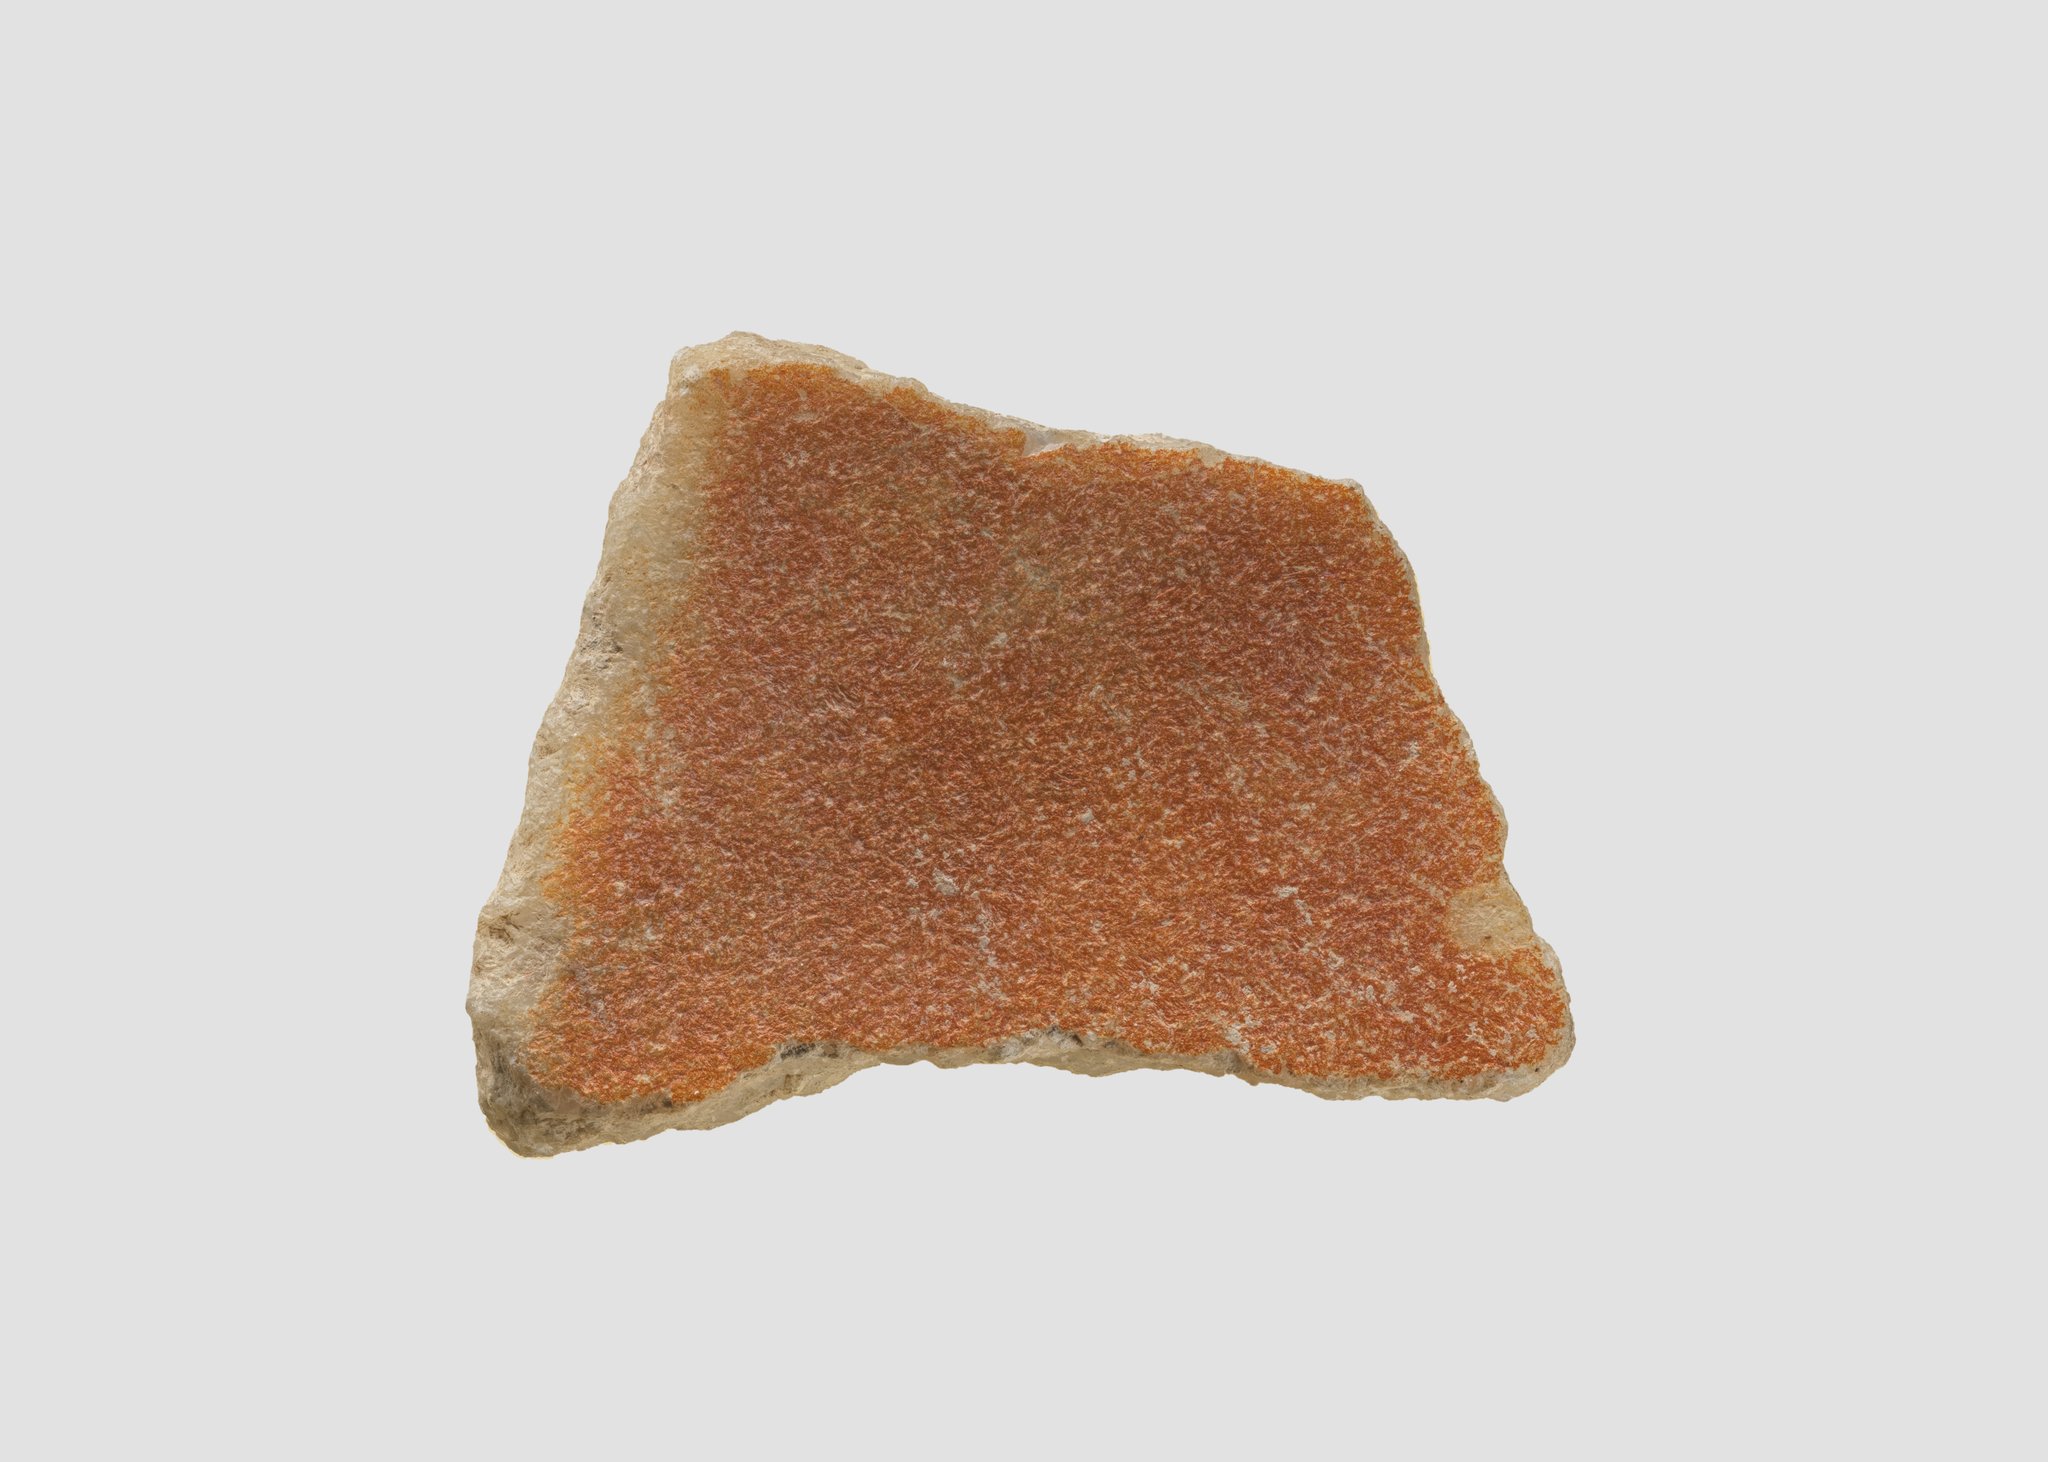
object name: plaque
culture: sasanian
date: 201-700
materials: marble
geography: mesopotamia